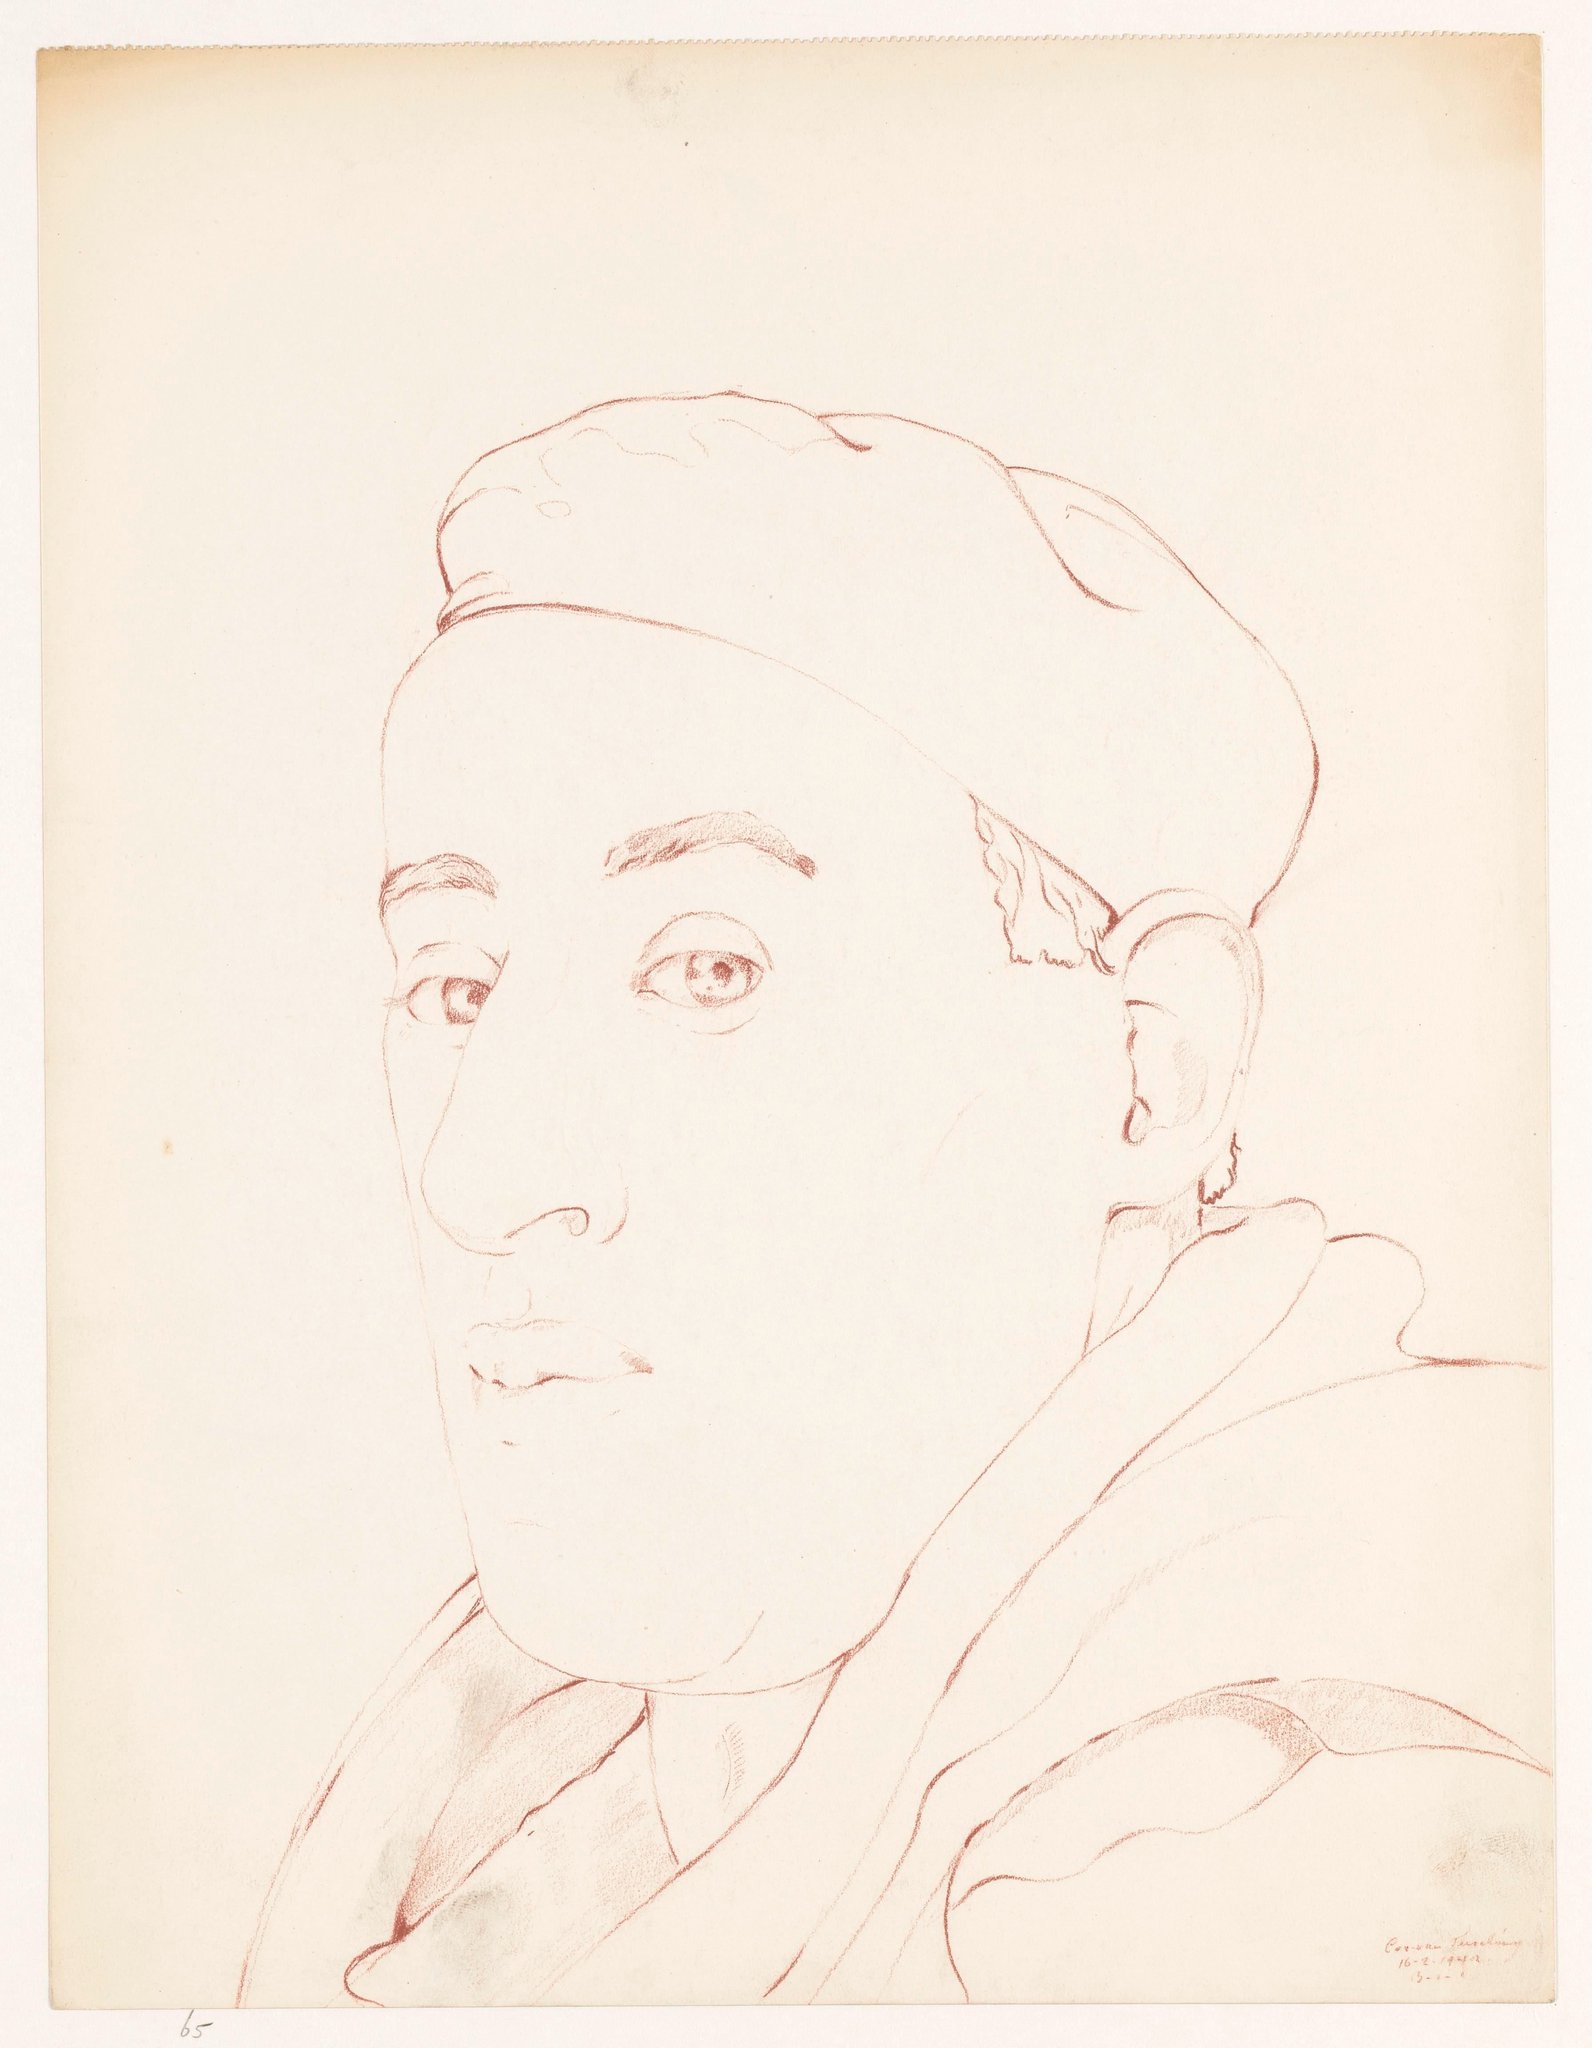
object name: drawing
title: Zelfportretten van Cor van Teeseling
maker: cor van teeseling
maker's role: draughtsman, sculptor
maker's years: 1915-1942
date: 1942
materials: paper, pencil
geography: weteringschans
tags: amsterdam, draughtsman, sculptor, cor van teeseling, historical persons, prisoner in cell or locked place, portrait, self-portrait of draughtsman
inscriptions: date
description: Zelfportret van Cor van Teeseling met pet: B-1-1, 16 februari. Getekend zelfportret van Cor van Teeseling driekwart naar links kijkend, met pet.